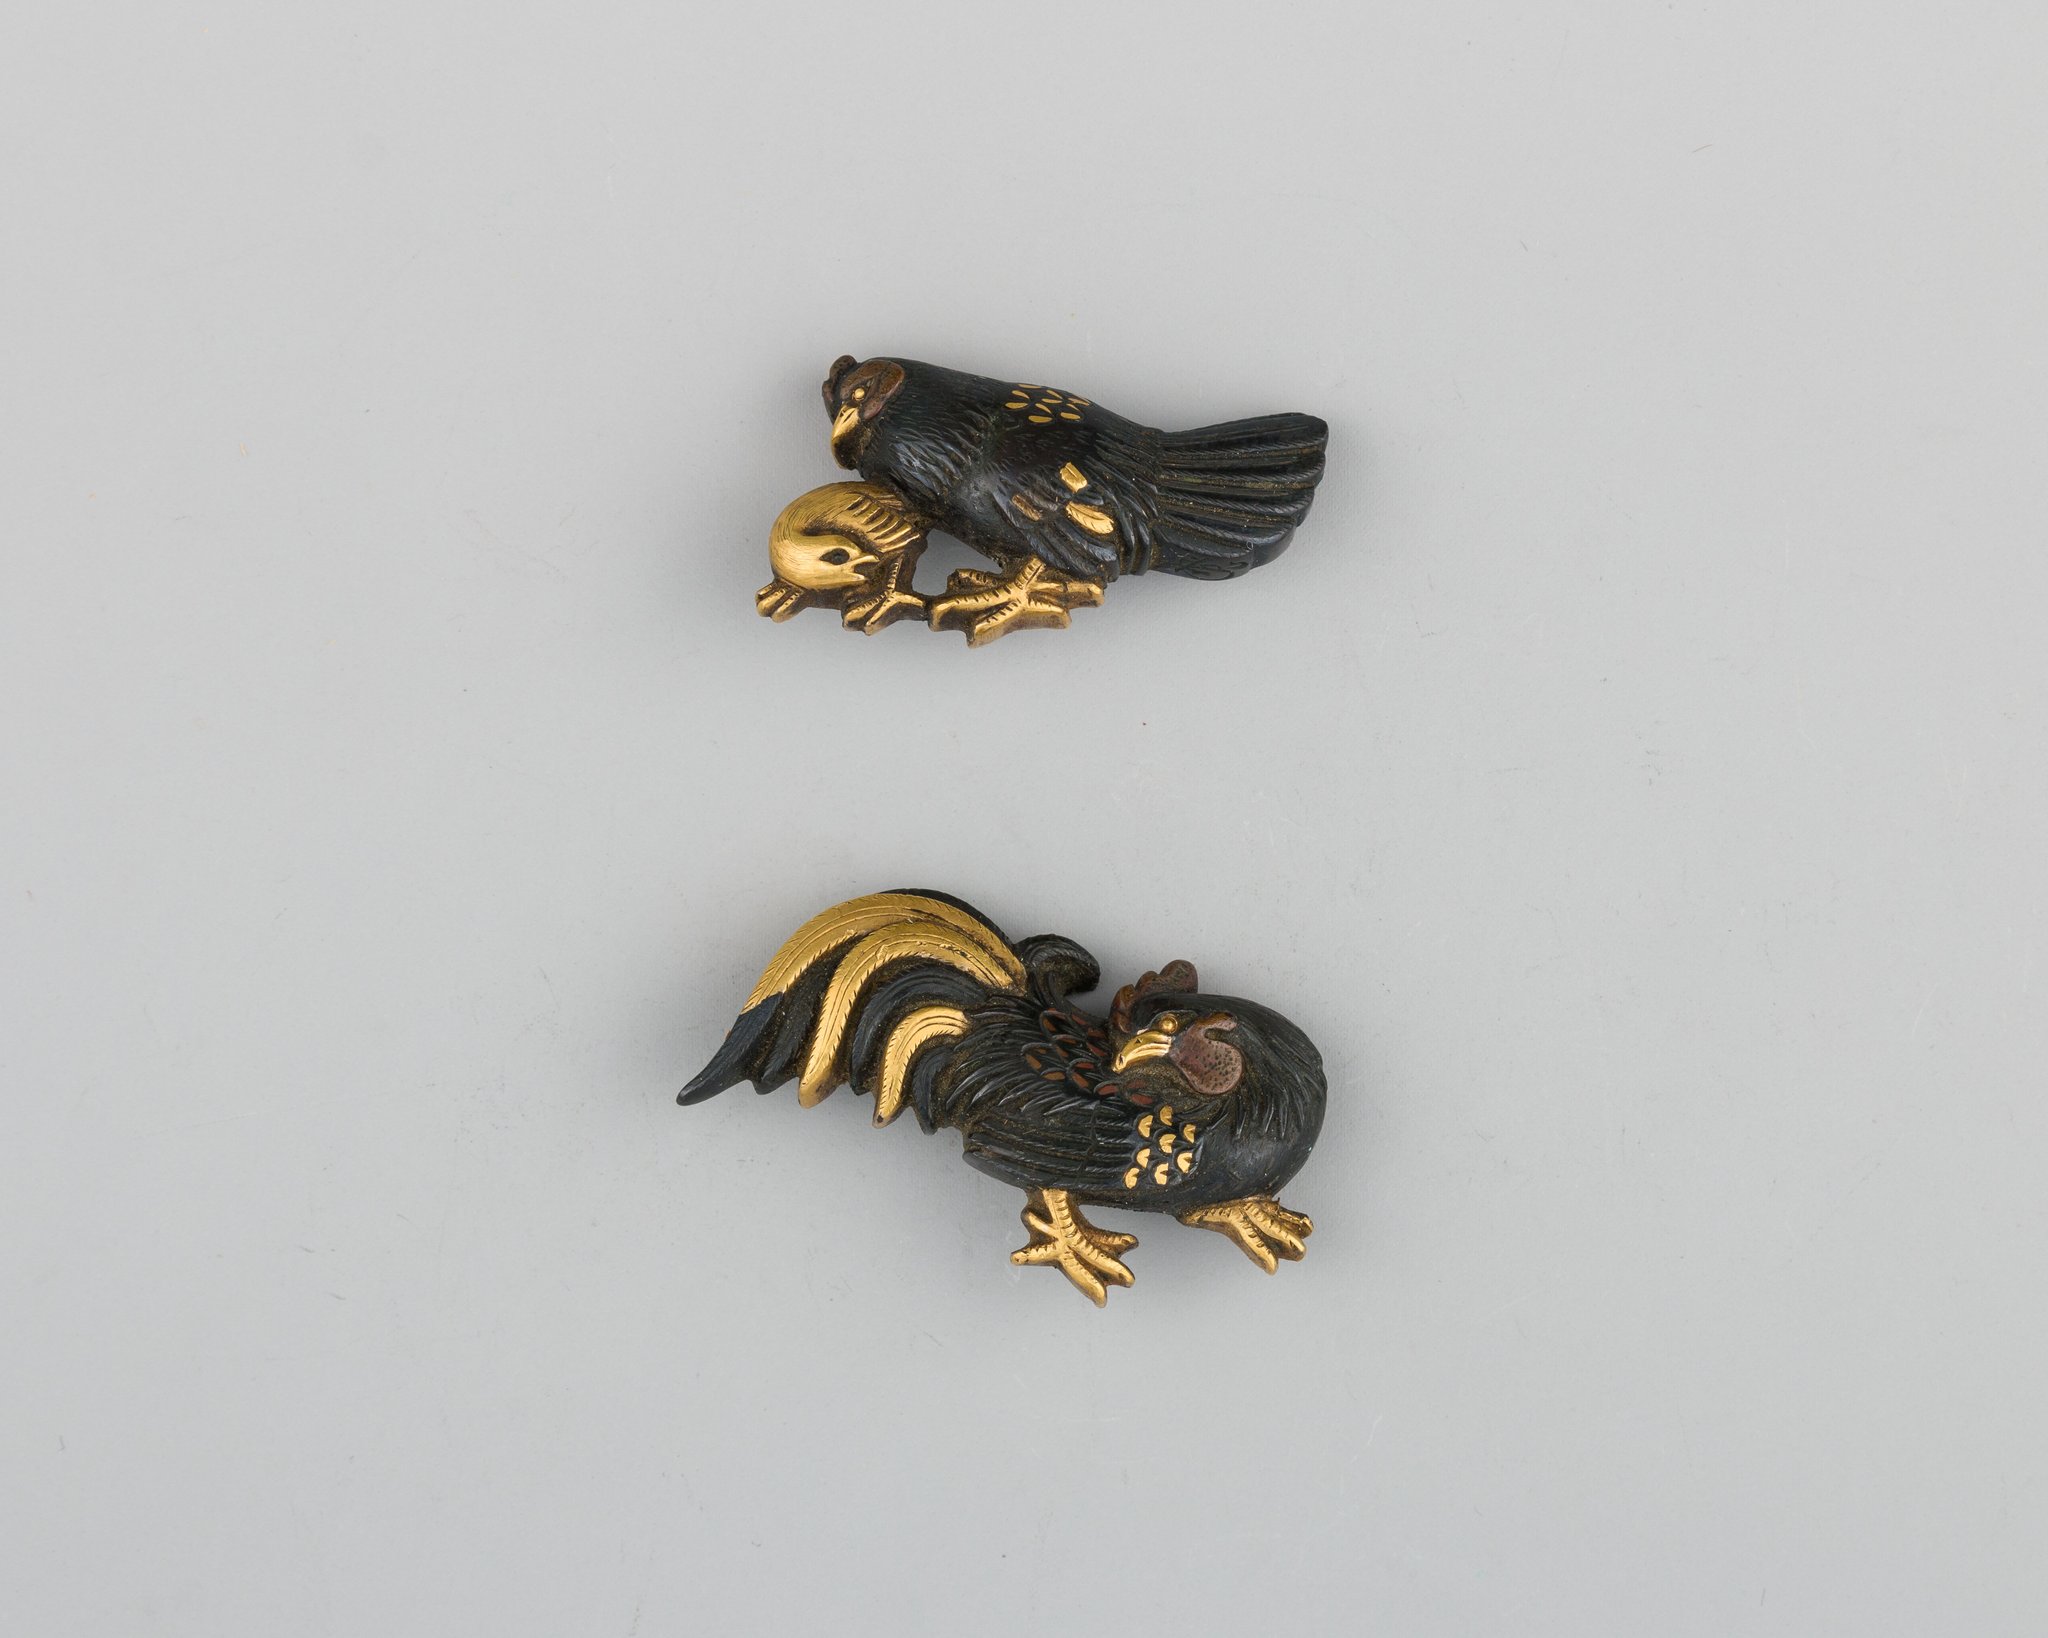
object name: pair of sword grip ornament menuki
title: Pair of Sword-Grip Ornaments (Menuki)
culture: japanese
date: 1701-1800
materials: copper, gold alloy, gold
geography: japan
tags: birds,roosters